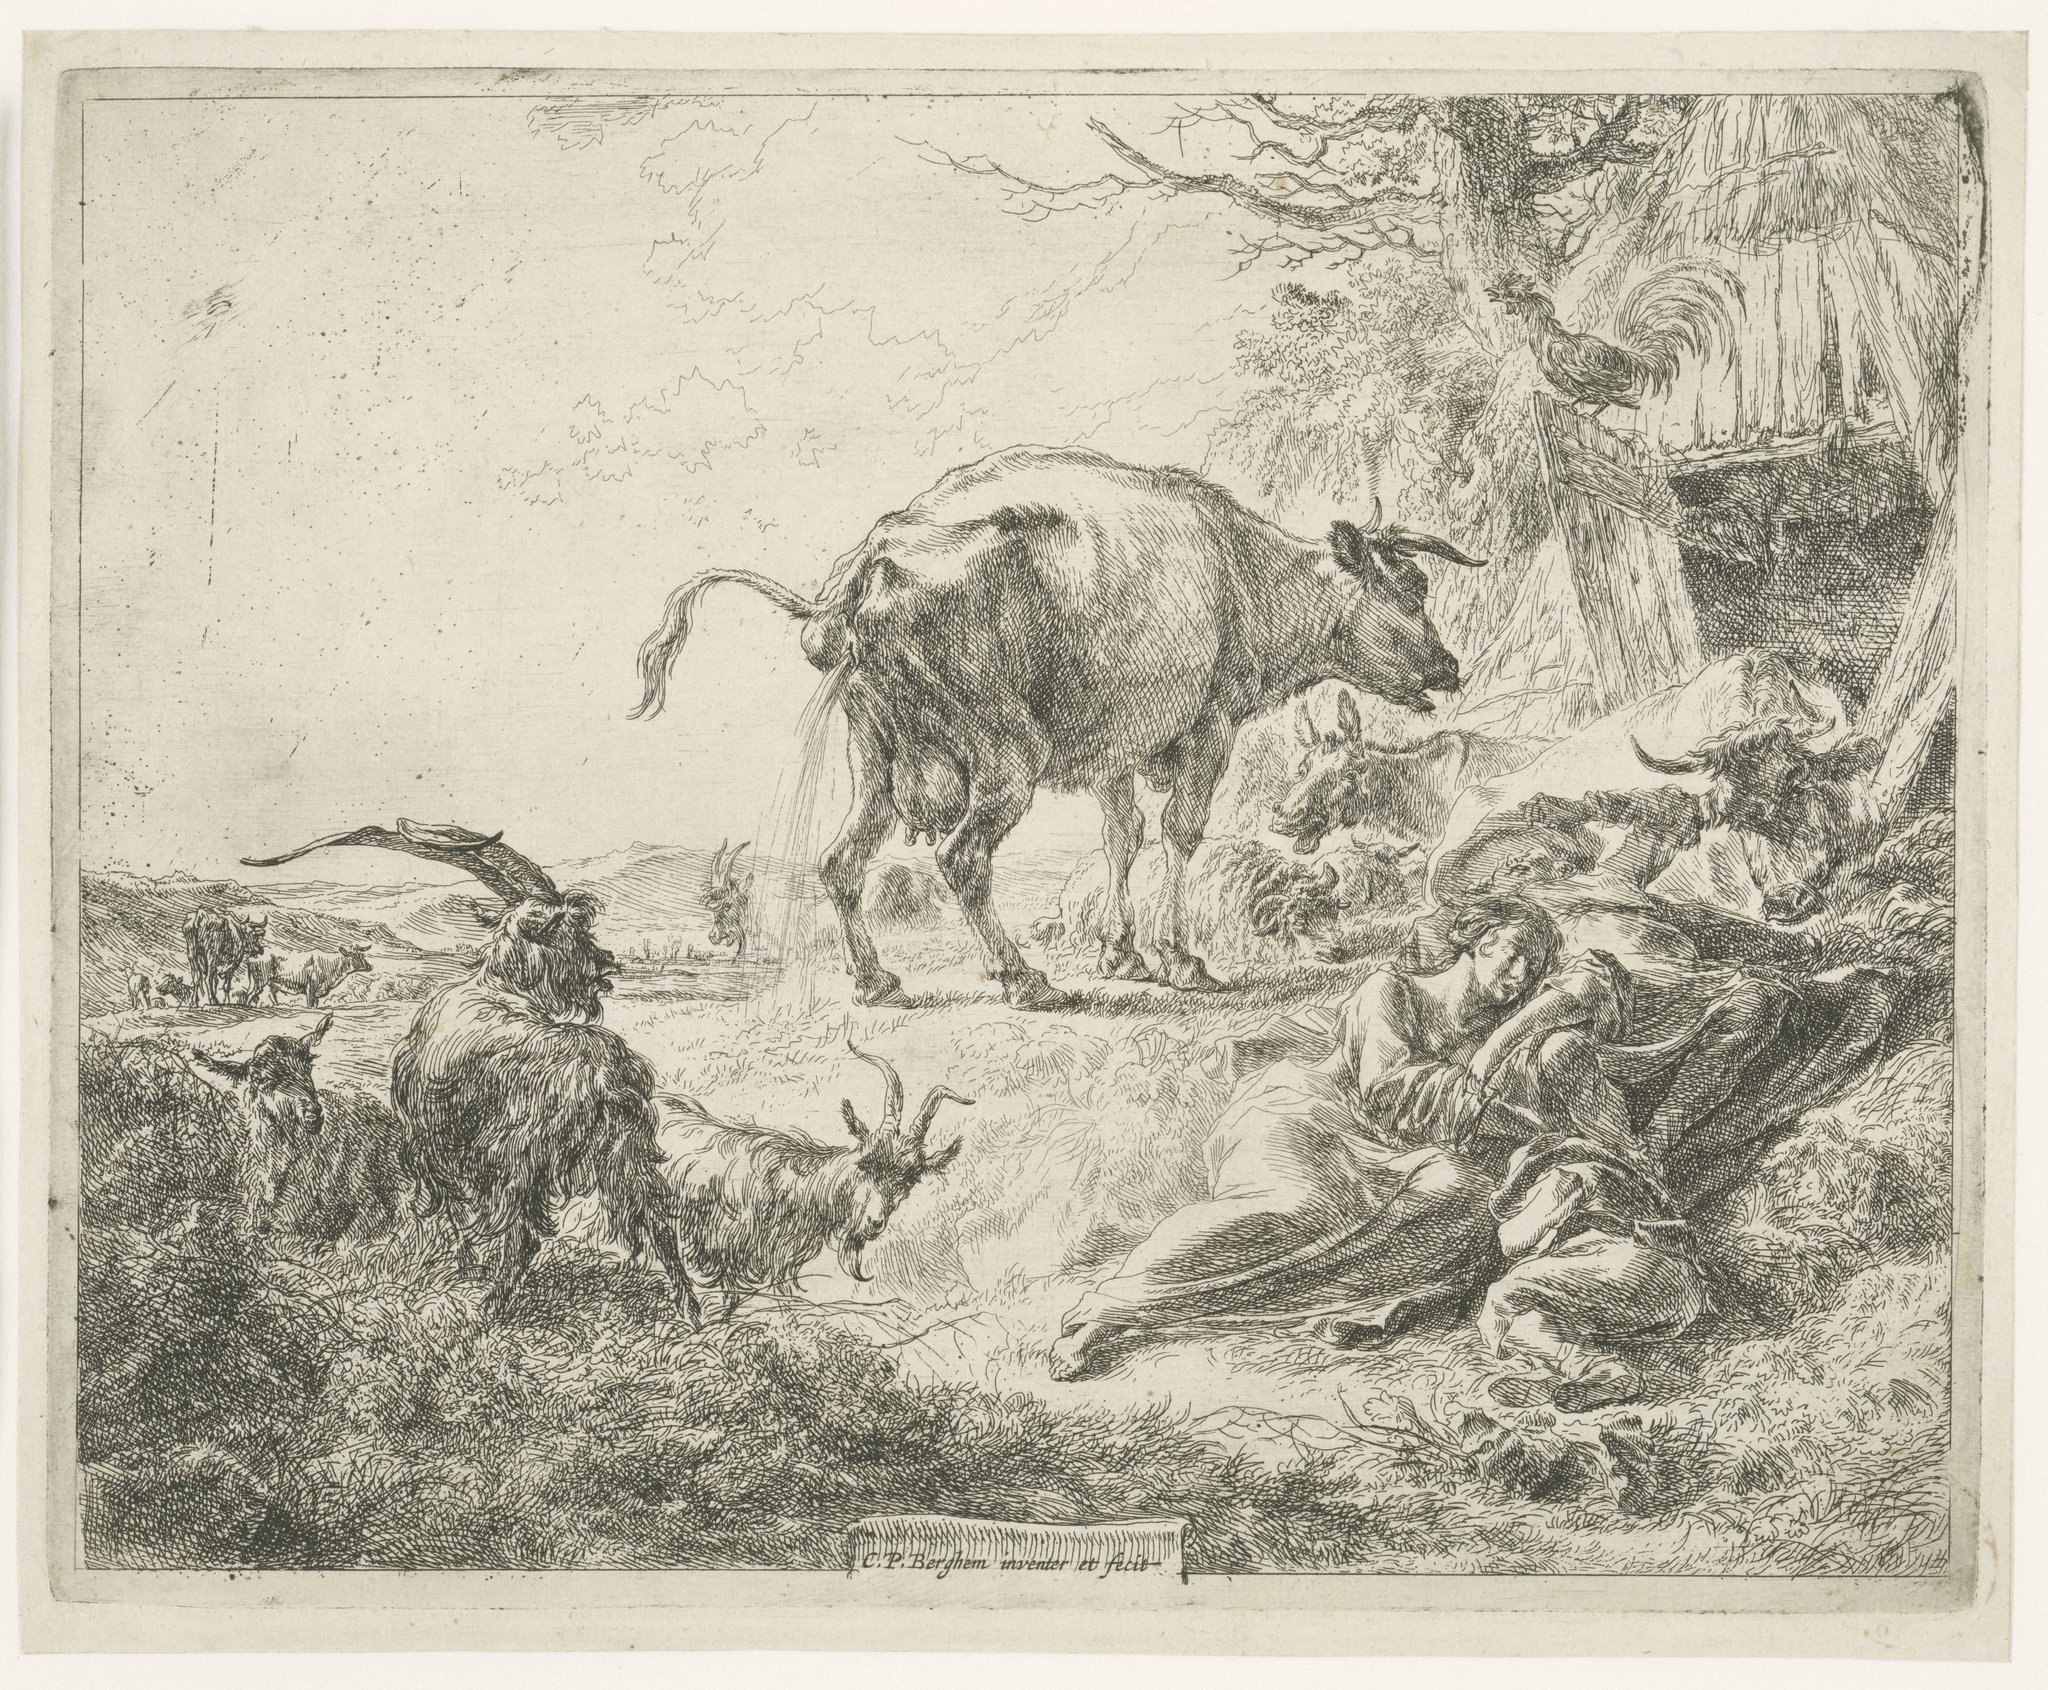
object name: print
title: De pissende koe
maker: nicolaes pietersz berchem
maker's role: draughtsman, print maker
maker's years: 1620-1683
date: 1650-1652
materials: paper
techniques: etching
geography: netherlands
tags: cow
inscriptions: collector's mark: Lugt 240